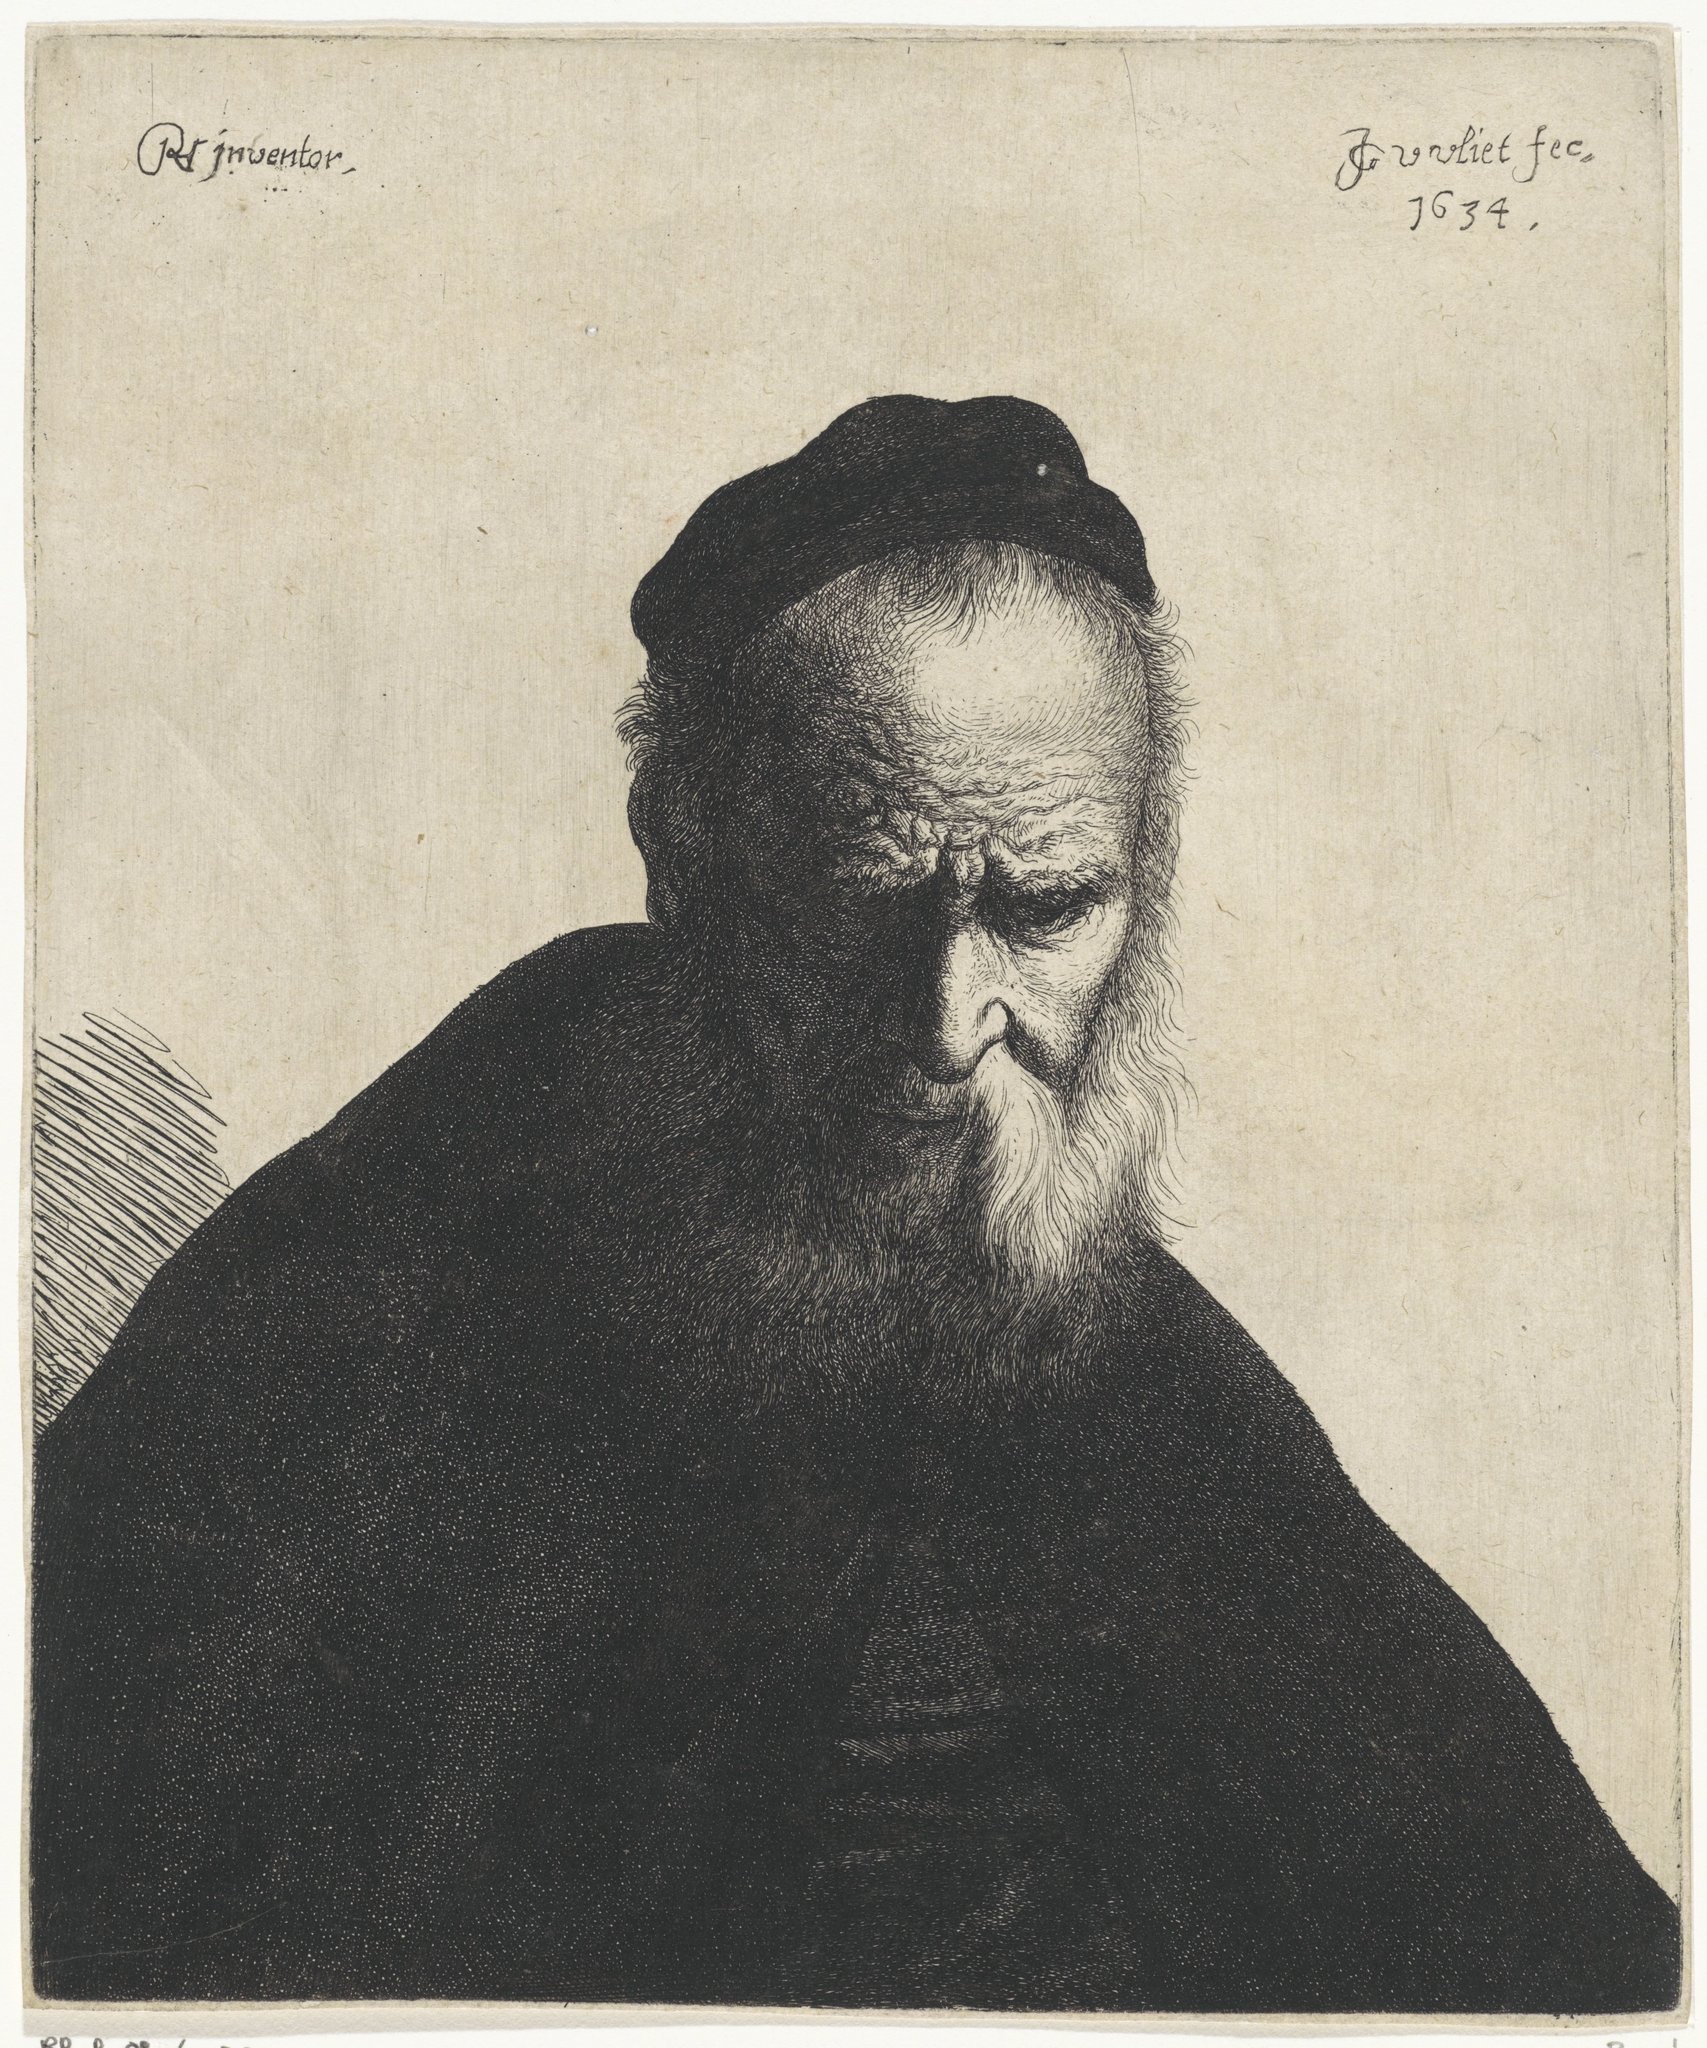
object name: print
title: Tronies naar Rembrandt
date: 1634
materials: paper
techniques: engraving, etching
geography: leiden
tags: head-gear: cap (+ men's clothes), beard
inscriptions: collector's mark: Lugt 240